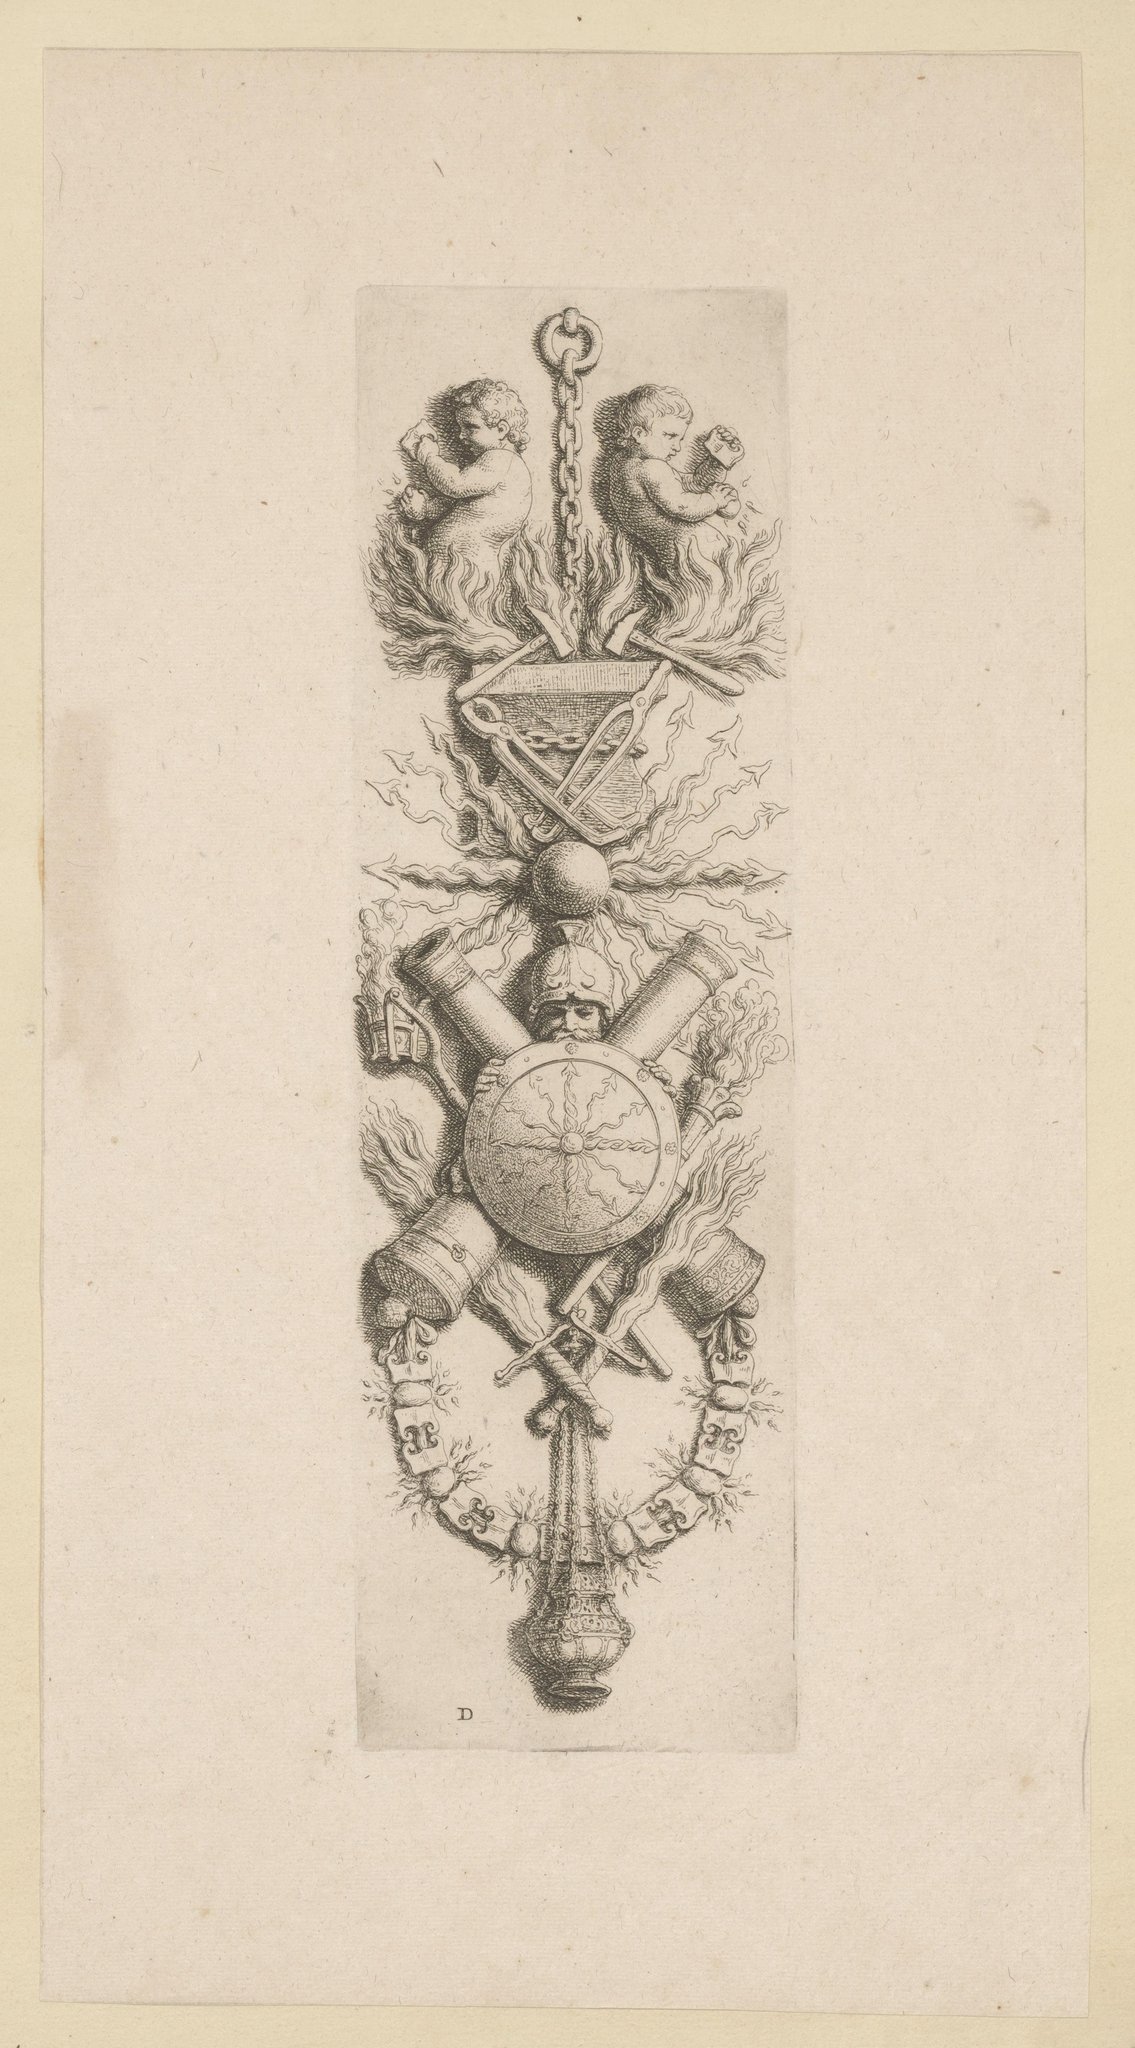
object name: print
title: Festoen met attributen van de personificatie van het element Vuur aan oostzijde van de Burgerzaal in het Stadhuis op de Dam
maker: hubert quellinus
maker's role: print maker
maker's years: 1619-1687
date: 1663-1668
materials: paper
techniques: engraving, etching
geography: amsterdam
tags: fire (one of the four elements), townhall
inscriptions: collector's mark: ‘16,70’ Lugt 1641b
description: Huidige staat van prent ook gebruikt in: Secunca pars Praecipuarum effigierum ac ornamentorum amplissime Curiae Amstelrodamensis maiori ex parte in cadido marmore effectorum per Artum Quellinium eiusdem Civitatis Statuarium / Het tweede deel Van de voornaemste Statuen ende Cieraten van 't konst-rijcke Stadt-huys van Amstelredam 'tmeeste in Marmer gemaeckt door Artus Quellinus Beelthouwer der voorseyde Stadt. Amsterdam: Artus Quellinus (I), 1663. En in: Secunca pars Praecipuarum effigierum ac ornamentorum amplissime Curiae Amstelrodamensis maiori ex parte in cadido marmore effectorum per Artum Quellinium eiusdem Civitatis Statuarium / Het tweede deel Van de voornaemste Statuen ende Cieraten van 't konst-rijcke Stadt-huys van Amstelredam 'tmeeste in Marmer gemaeckt door Artus Quellinus Beelthouwer der voorseyde Stadt. Amsterdam: Frederik de Wit, 1668. Latere staat van prent ook gebruikt in: Architecture peinture et sculpture de la Maison de Ville d'Amsterdam, representee en CIX. figures en taille-douce (…). Amsterdam: David Mortier, 1719. En in: Architecture peinture et sculpture de la Maison de Ville d'Amsterdam, representee en CIX. figures en taille-douce (…). Amsterdam: Gerard Valck, 1719. En in: Bouw schilder en beeldhouwkonst, van het Stadhuis te Amsteldam, vertoont in CIX figuuren (…). Amsterdam: Covens & Mortier & Covens Jr., s.a. (1774-1783).